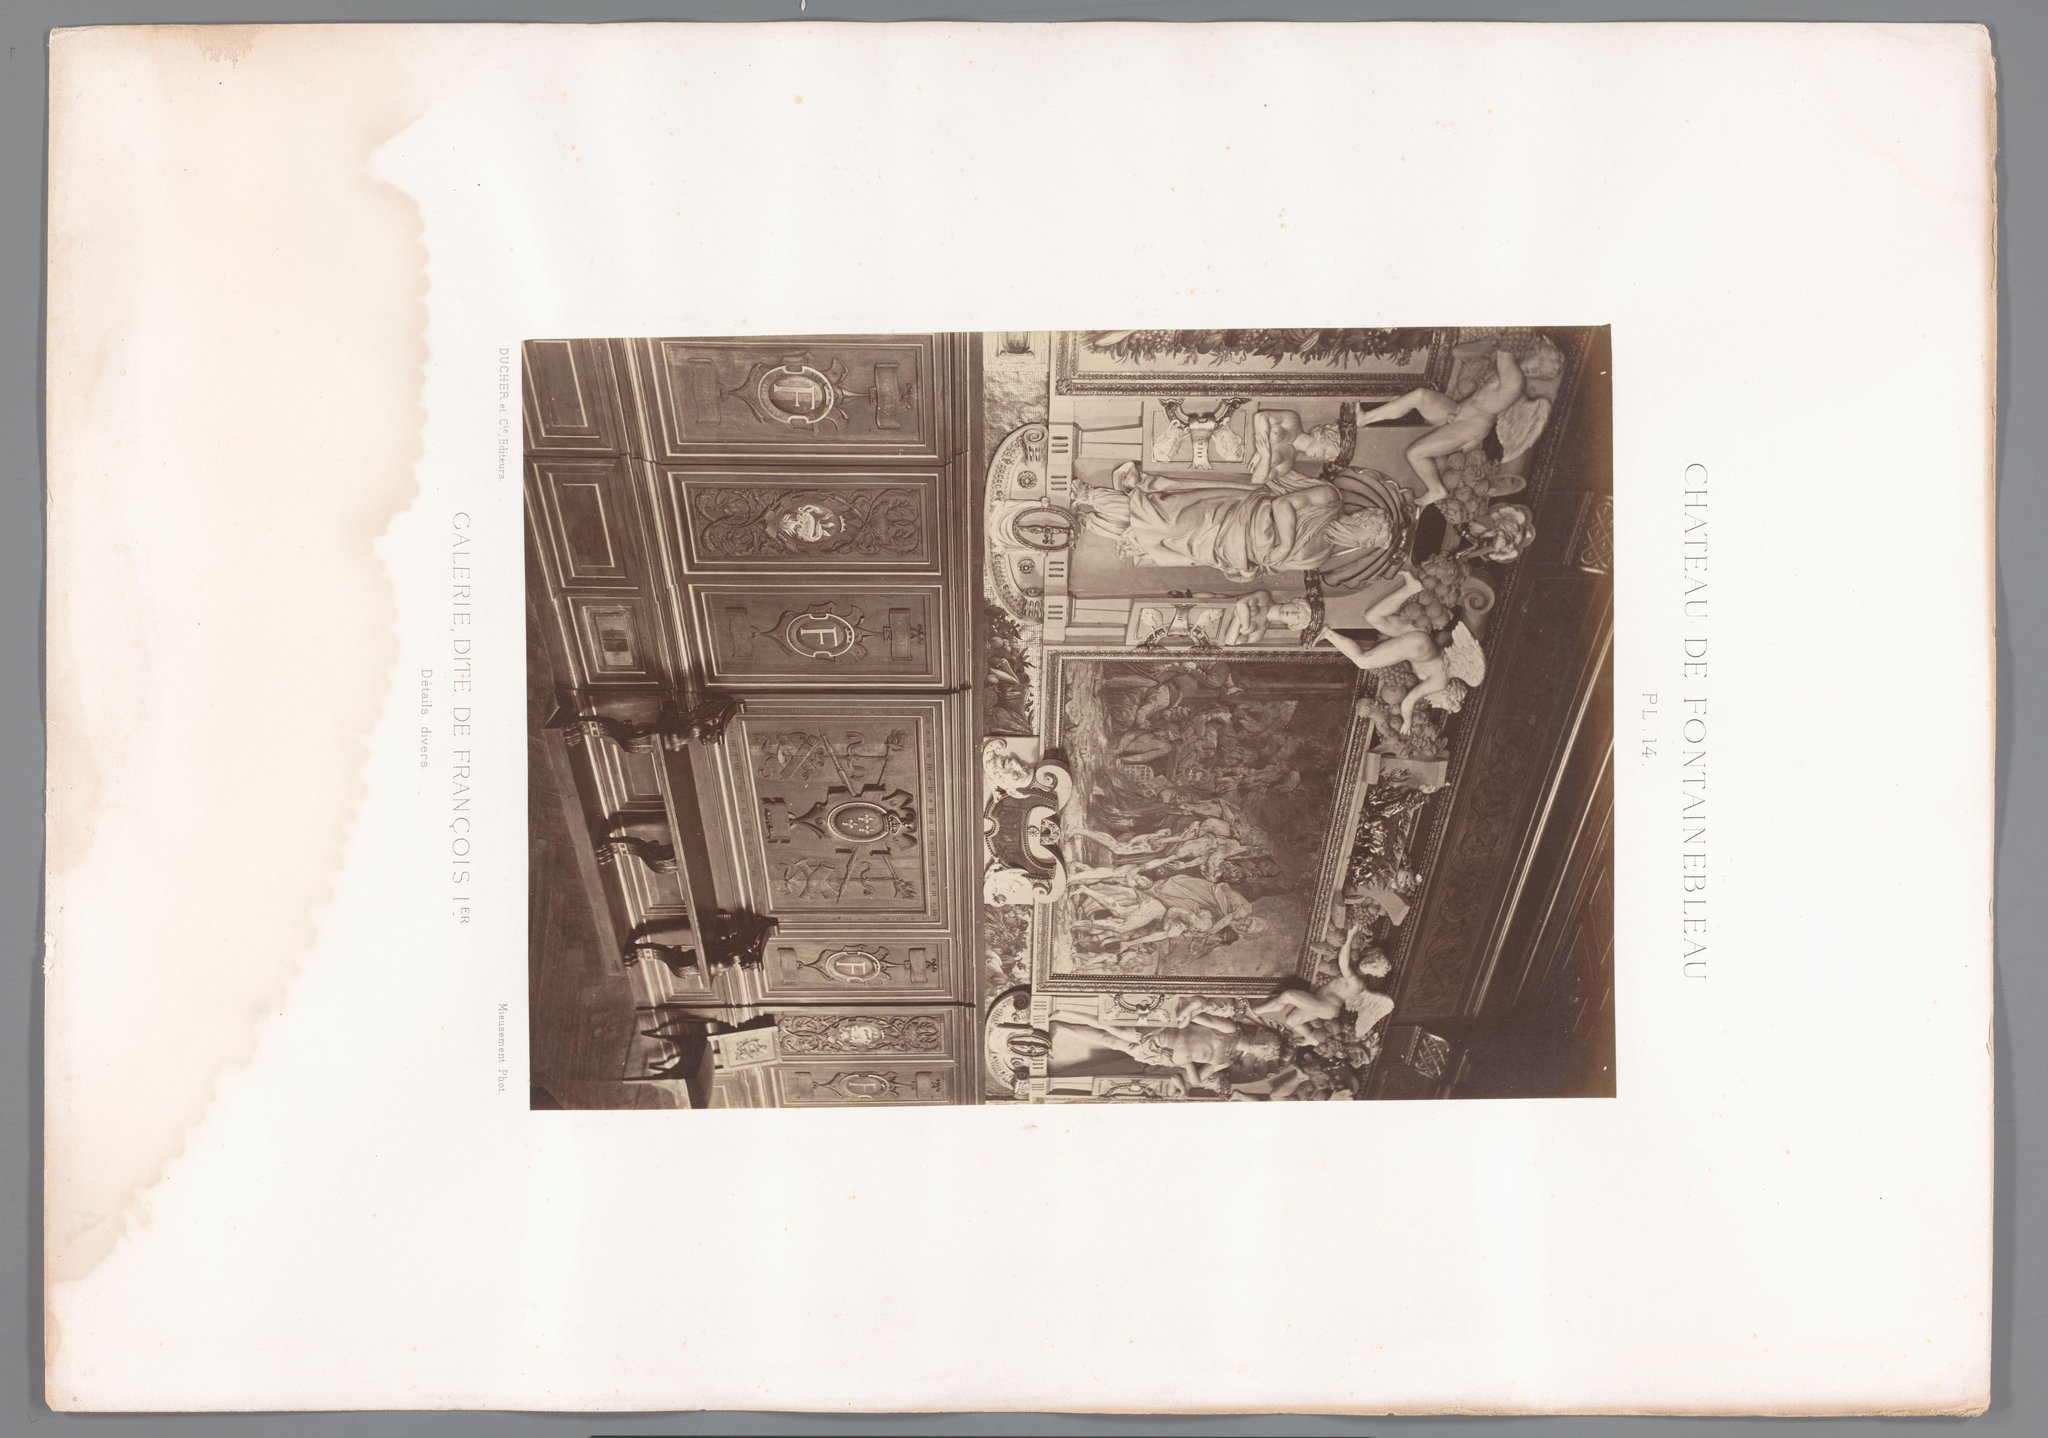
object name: photograph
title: Chateau de Fontainebleau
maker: séraphin-médéric mieusement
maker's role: fotograaf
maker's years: 1840-1905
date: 1870-1875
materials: photographic support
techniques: albumen print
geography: fontainebleau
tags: castle - aa - civic architecture: inside, panelling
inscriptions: number: ‘PL. 14.’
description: Deze foto maakt deel uit van een omslag met dertig foto's en twee tekstbladen.